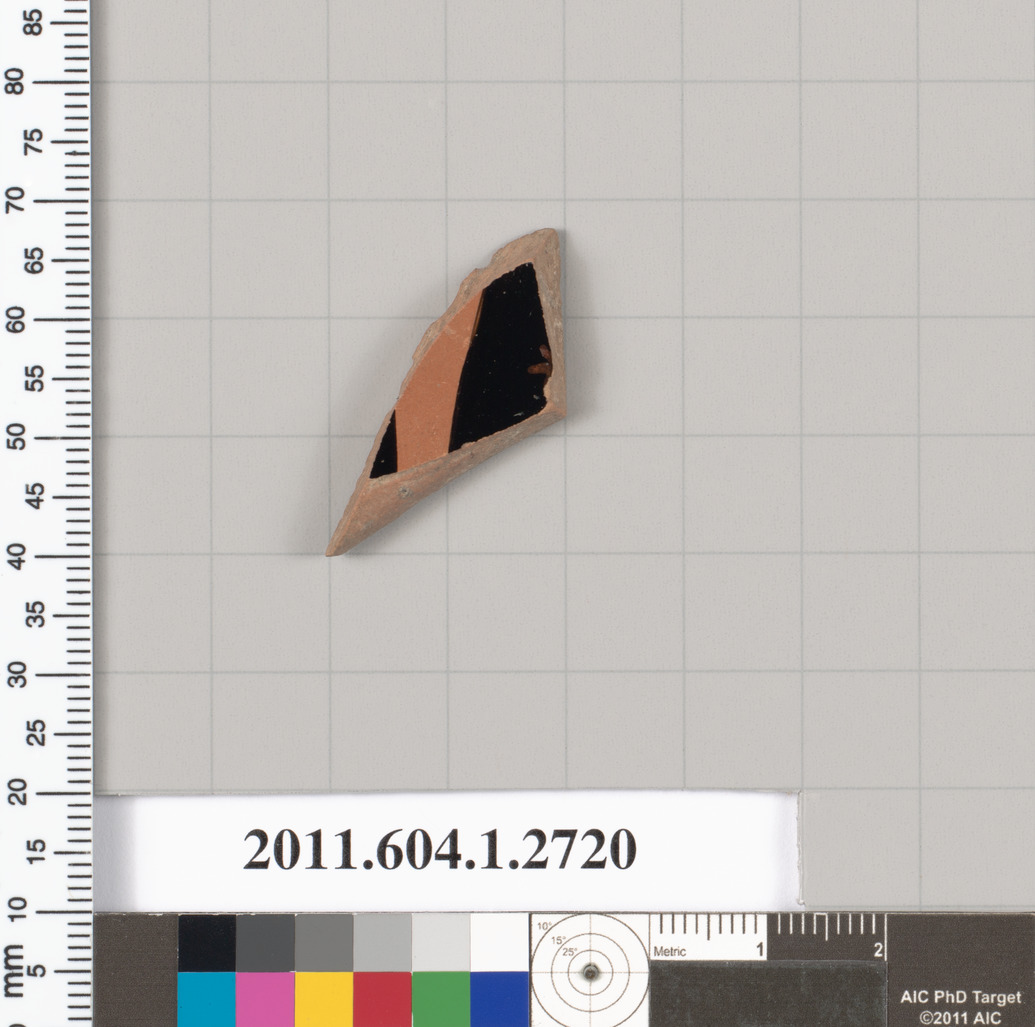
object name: kylix fragment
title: Terracotta fragment of a kylix (drinking cup)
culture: greek, attic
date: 500-480 BCE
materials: terracotta